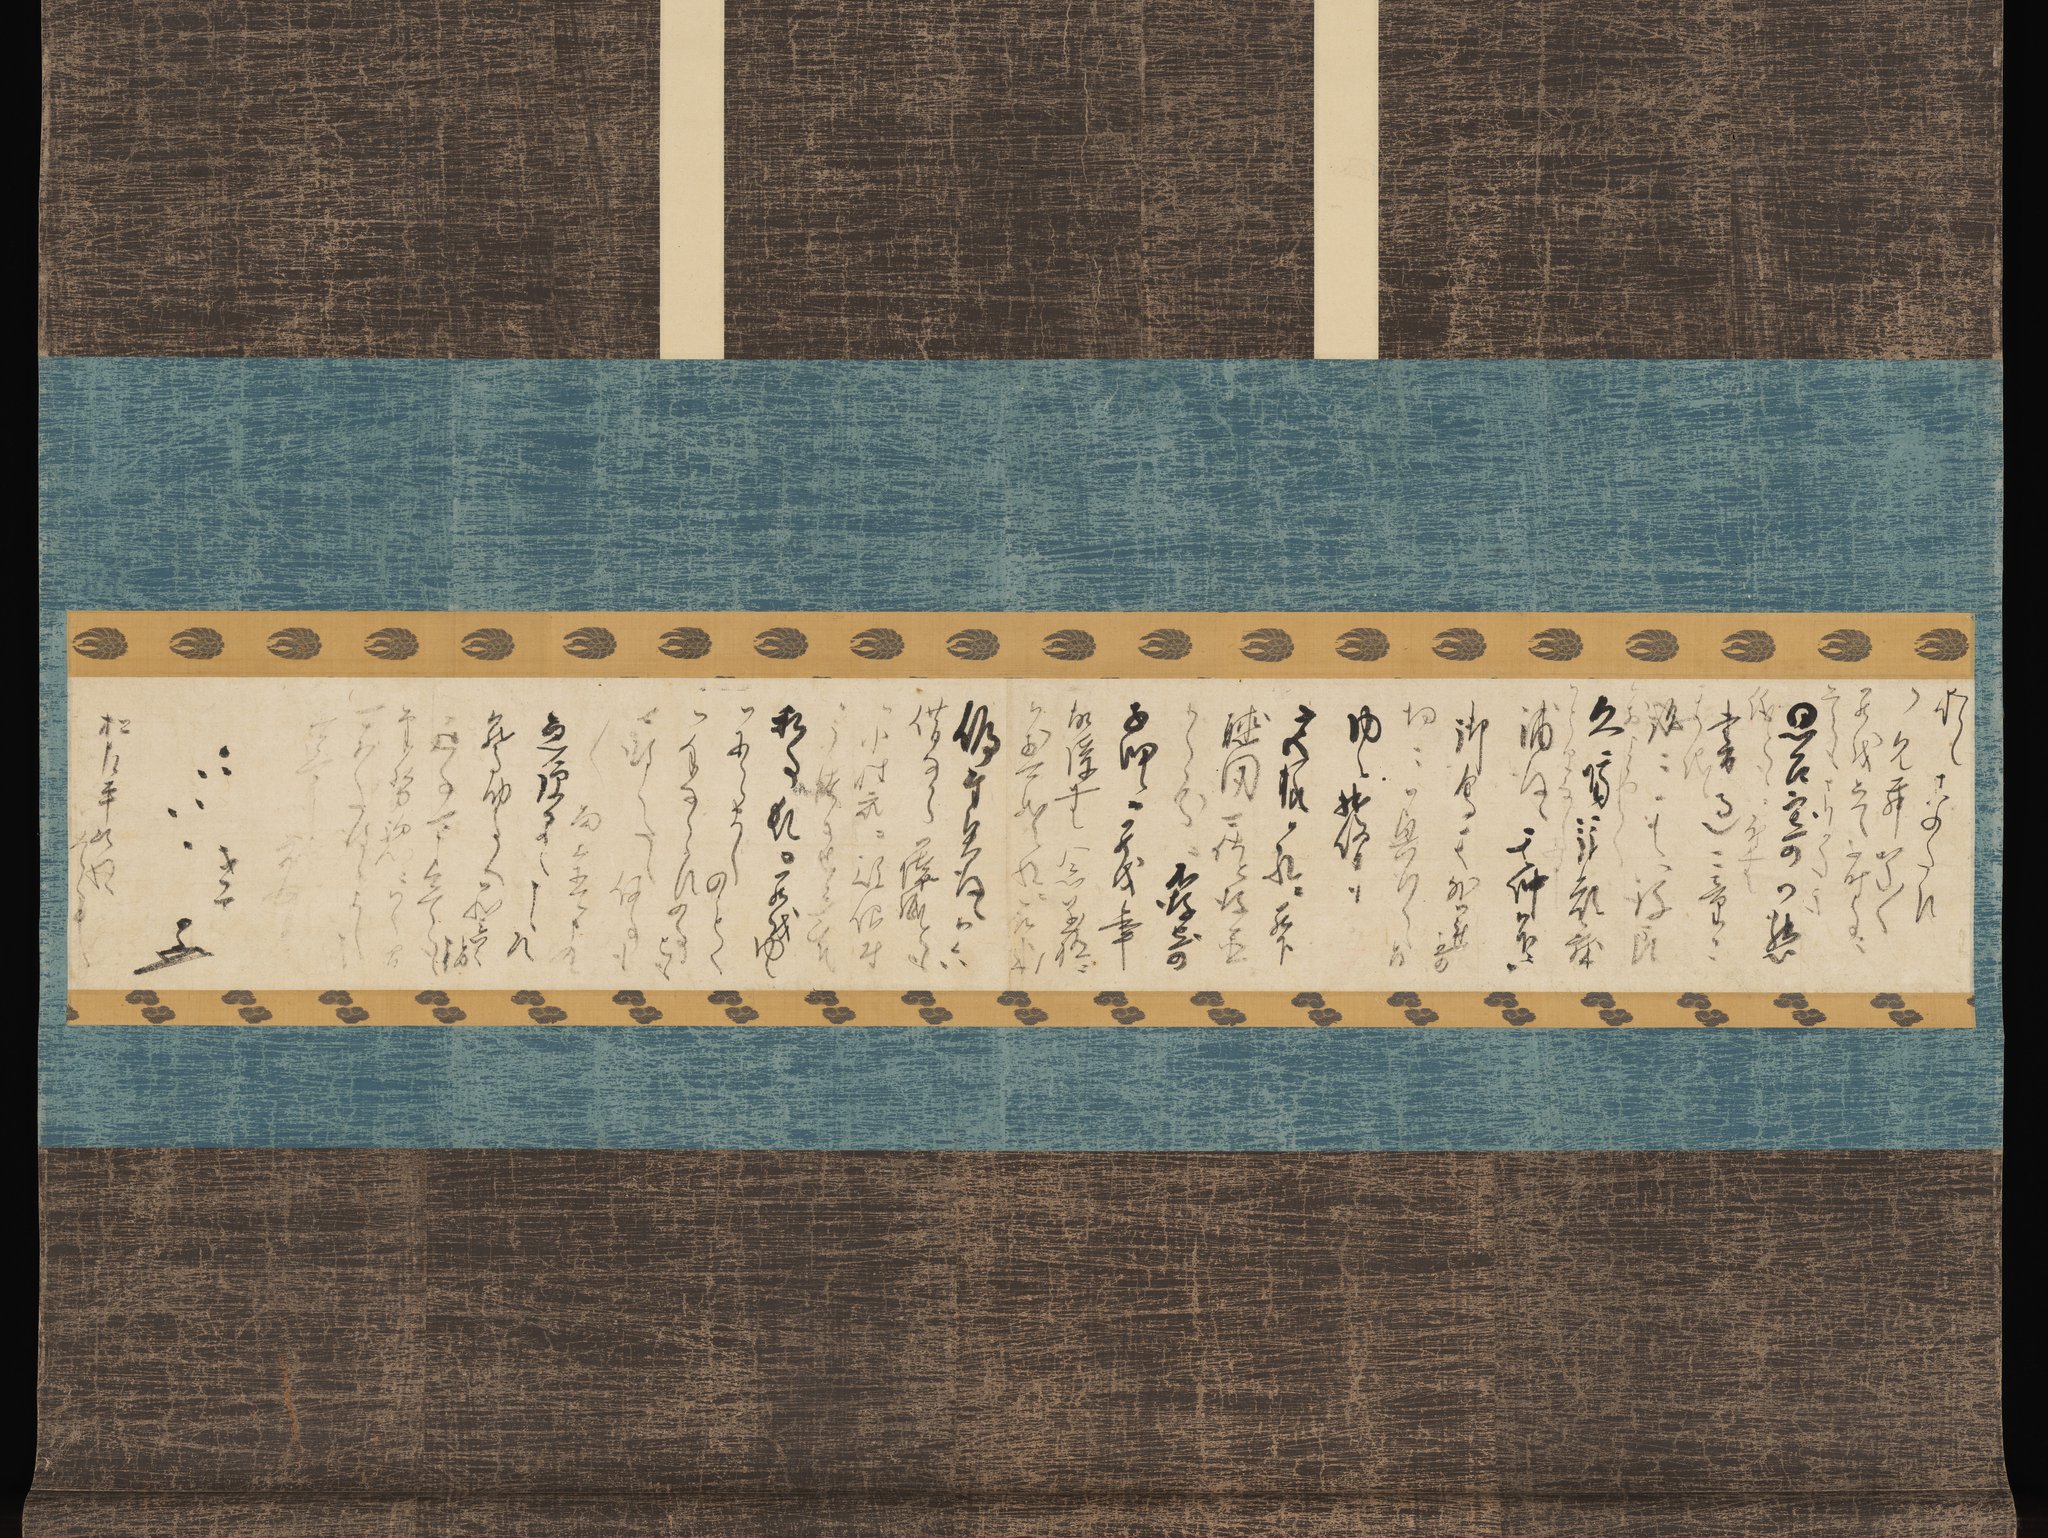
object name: hanging scroll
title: Letter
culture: japanese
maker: shōkadō shōjō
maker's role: artist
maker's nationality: japanese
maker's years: 1584-1639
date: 1601-1633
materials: ink, paper